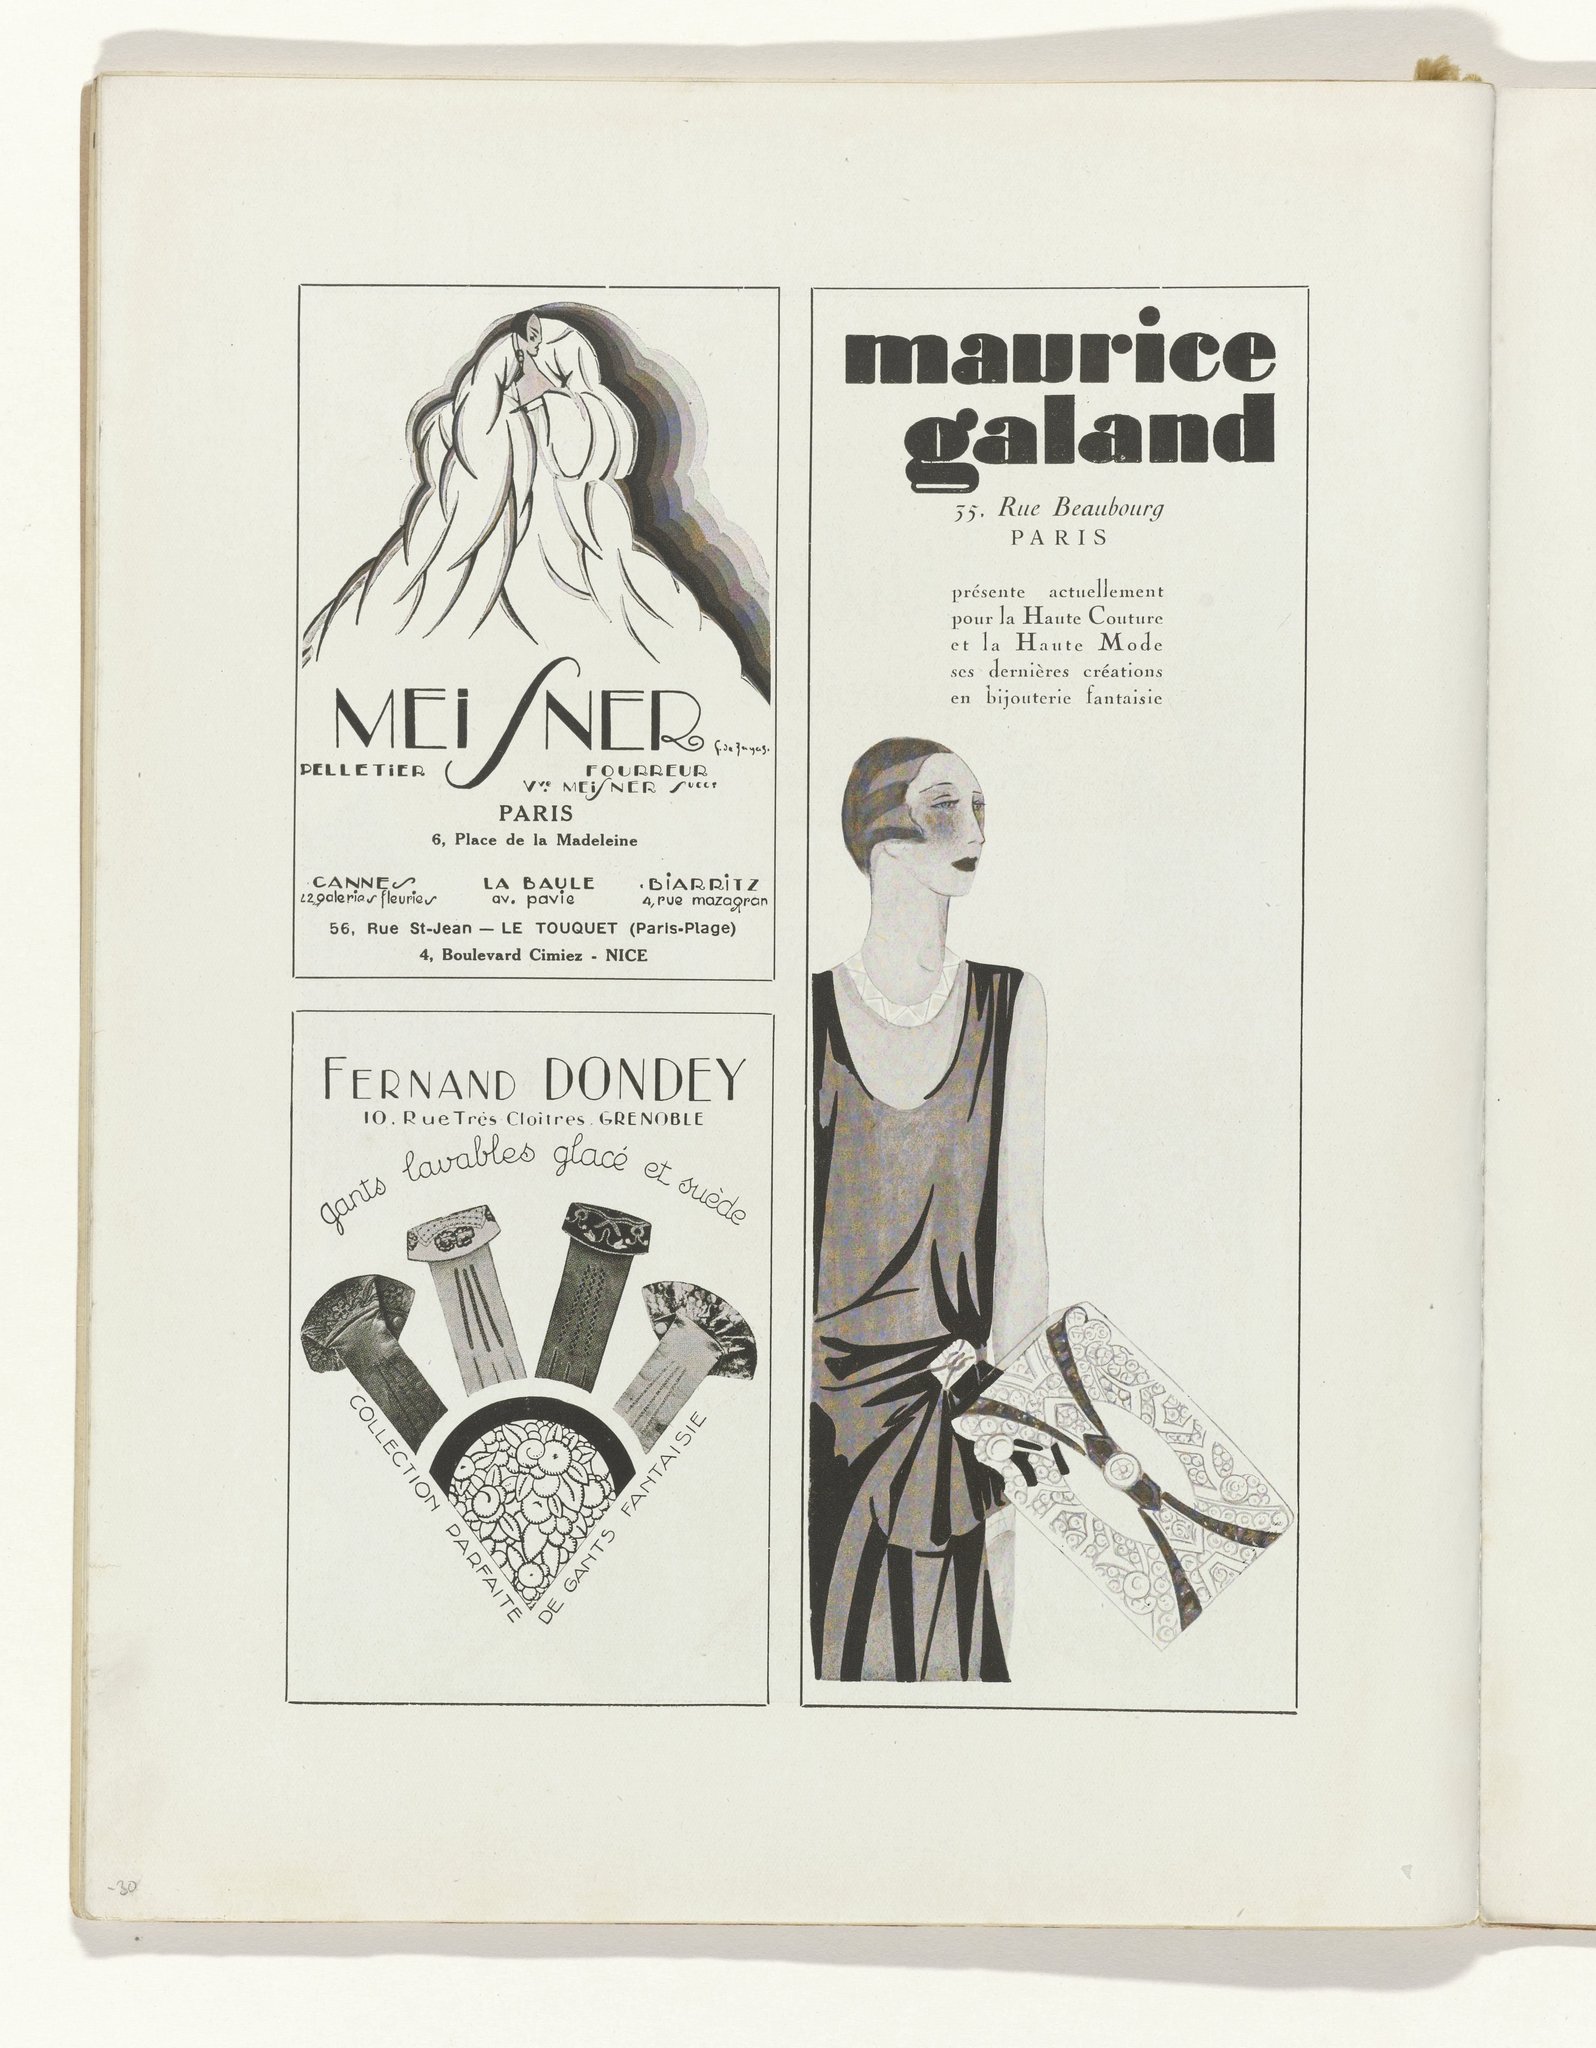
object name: magazine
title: Art - Goût - Beauté, Feuillets de l' élégance féminine, Mai 1929, No. 105, 9e Année, p. 31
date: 1929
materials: paper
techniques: photography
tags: gloves, mittens (short gloves) (+ women's clothes), fashion plates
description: Pagina uit het modetijdschrift Art-Goût-Beauté (1920-1933).